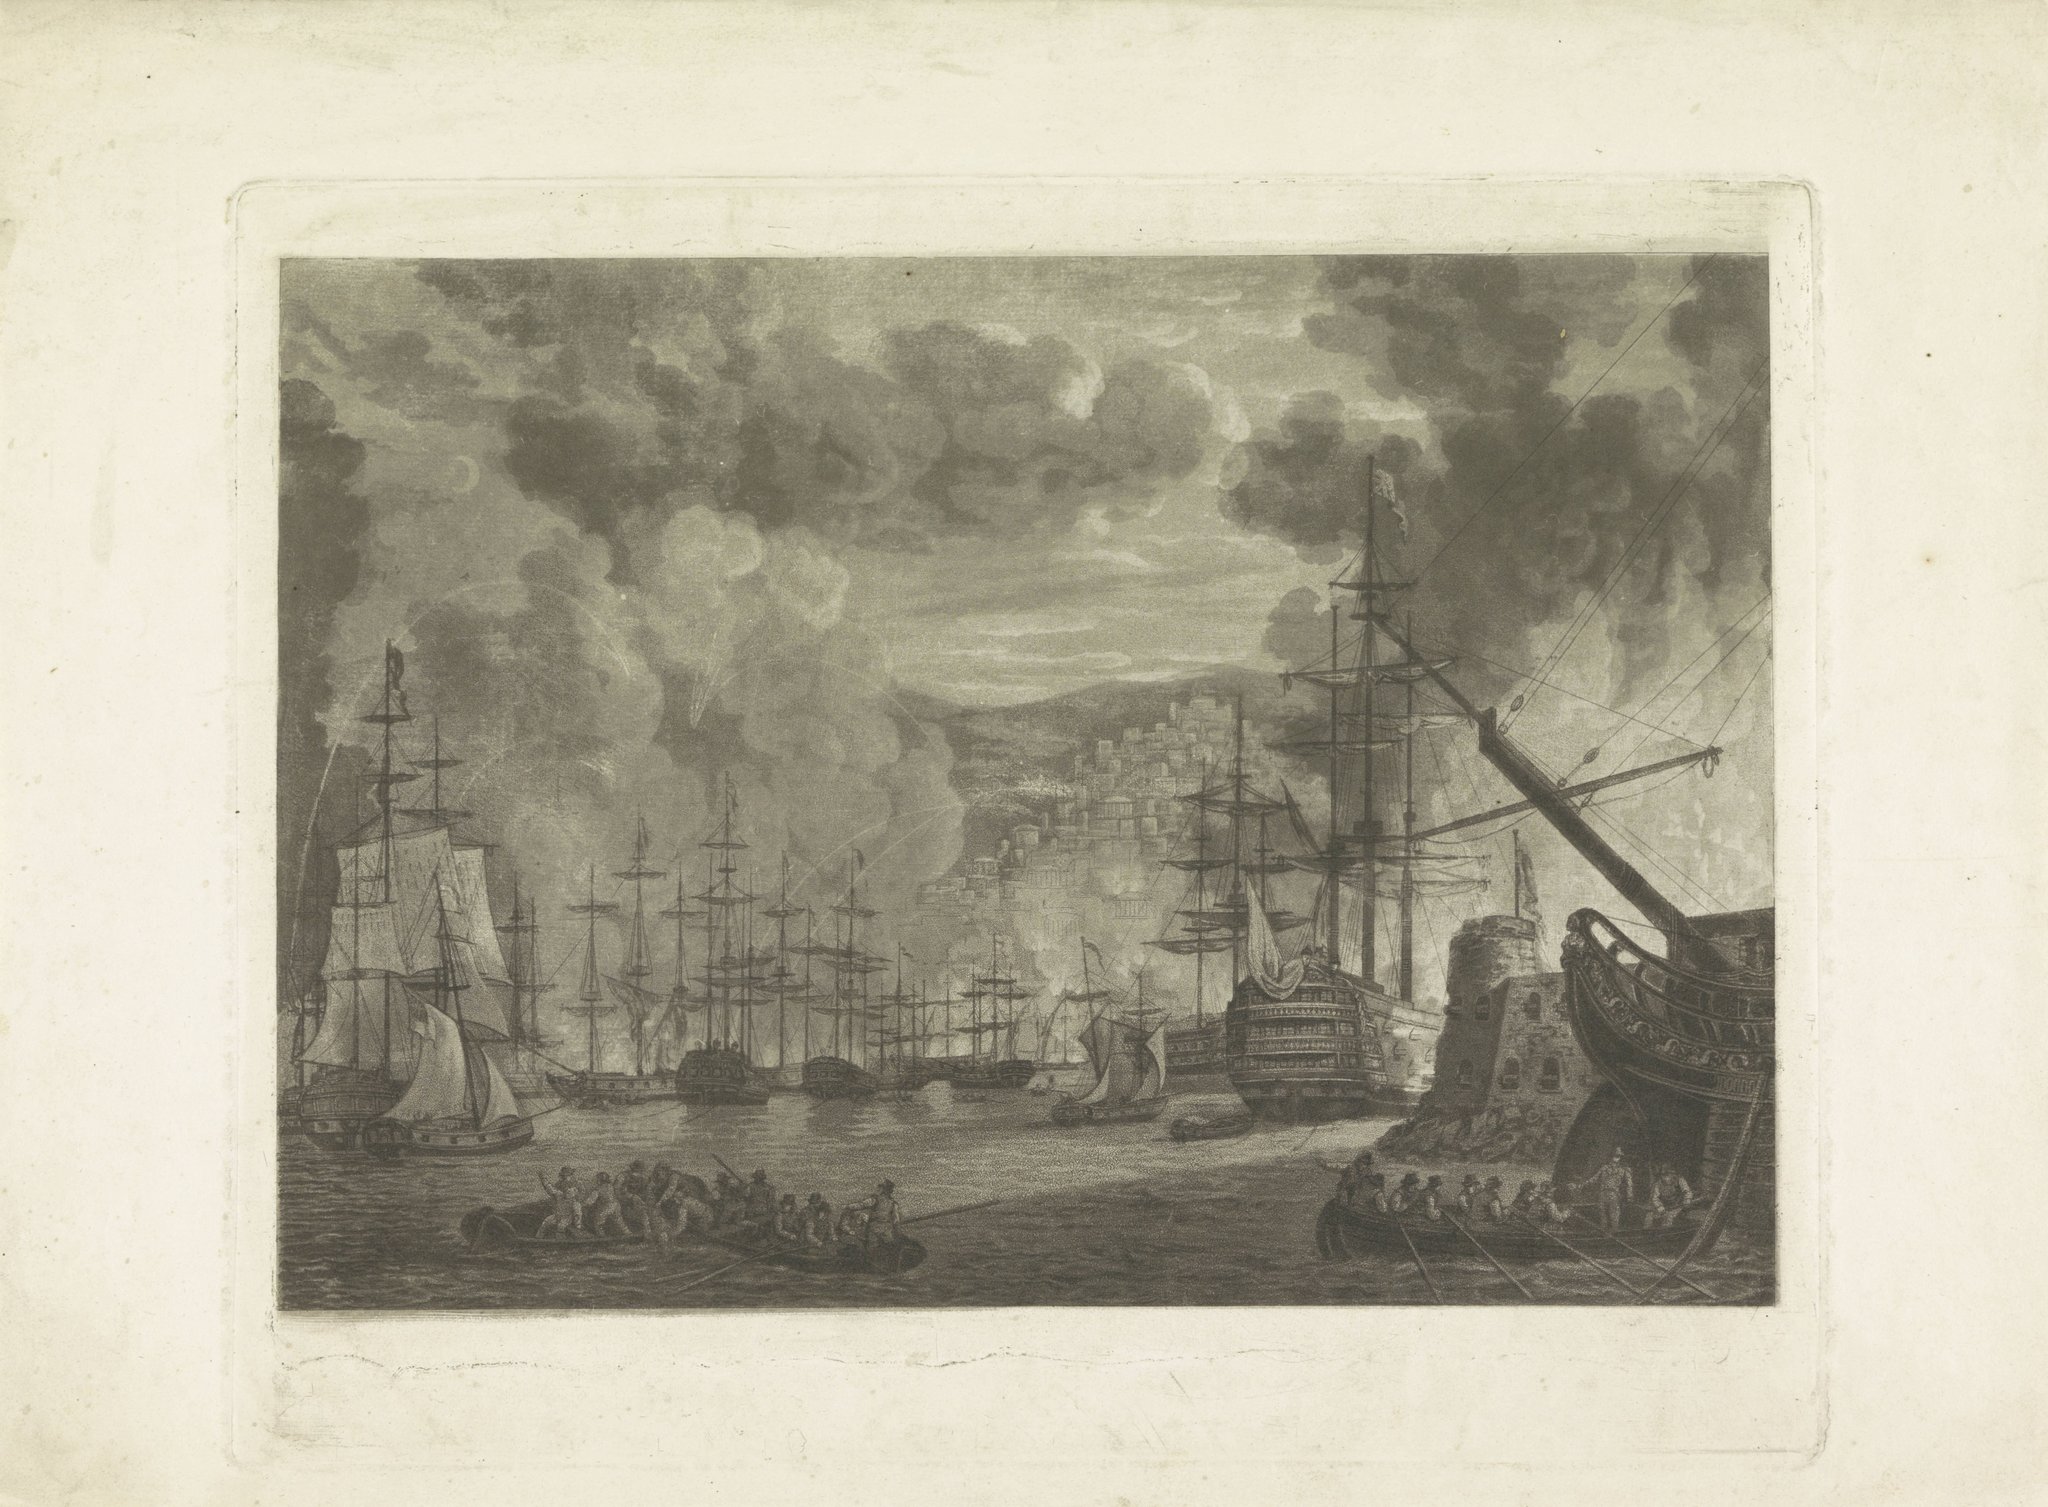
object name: print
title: Bombardement van Algiers, 1816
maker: nicolaus heideloff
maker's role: draughtsman, print maker, publisher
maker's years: 1761-1837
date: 1816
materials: paper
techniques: aquatint, etching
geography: the hague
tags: brussels, bombardment (+ sailing-ships), bombardment ~ siege (+ sailing-ships)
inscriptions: collector's mark: Lugt 2228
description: Het bombardement van Algiers in de nacht van 26-27 augustus 1816 door de gecombineerde Engels-Nederlandse vloot, onder commando van Lord Exmouth en jonkheer van Capellen. Links en rechts de brandende schepen van de zeerovers, in het midden de stad gelegen op een heuvel. Op de voorgrond enkele sloepen. Rechts een kustbatterij waarop een vlag.